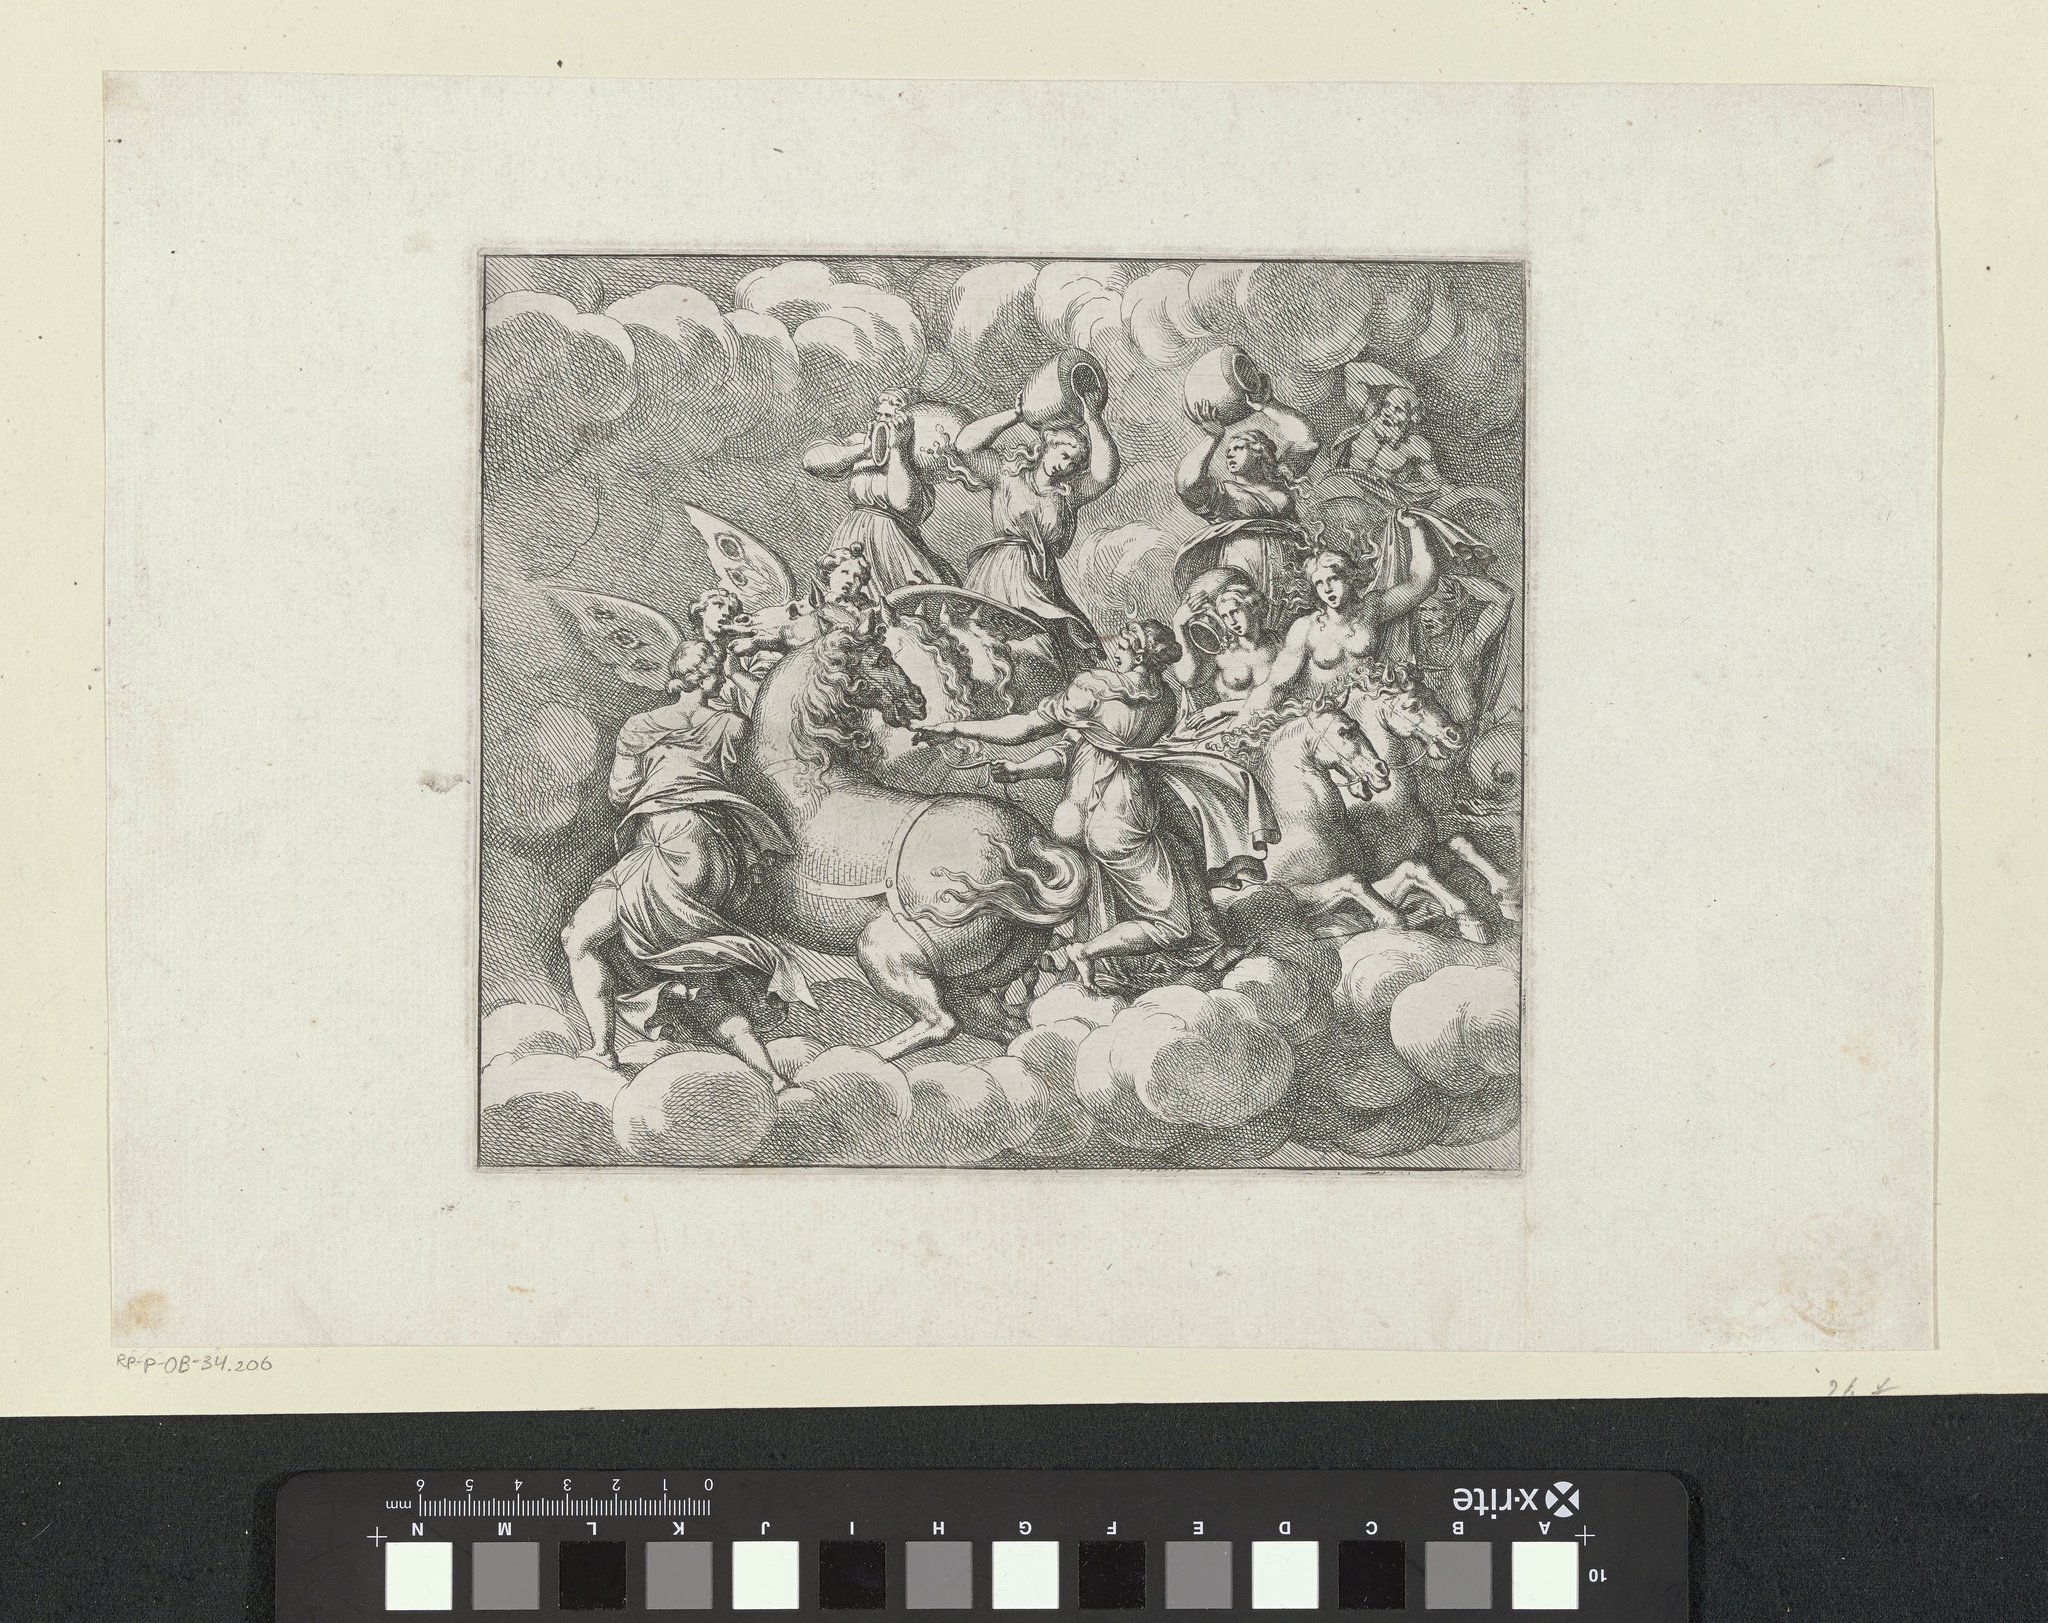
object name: print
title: Mythologische figuren tussen wolken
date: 1693-1700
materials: paper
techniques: engraving, etching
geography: rome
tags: (story of) diana (artemis), nymphs (in general); 'ninfe in commune' (ripa), (story of) aurora (eos); 'aurora' (ripa)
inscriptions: collector's mark: Lugt 240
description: Prent uit een reeks van negen prenten naar de wand- en plafondschilderingen ontworpen door Giulio Romano voor de Sala dei Giganti in Palazzo del Te in Mantua (1523-1535).